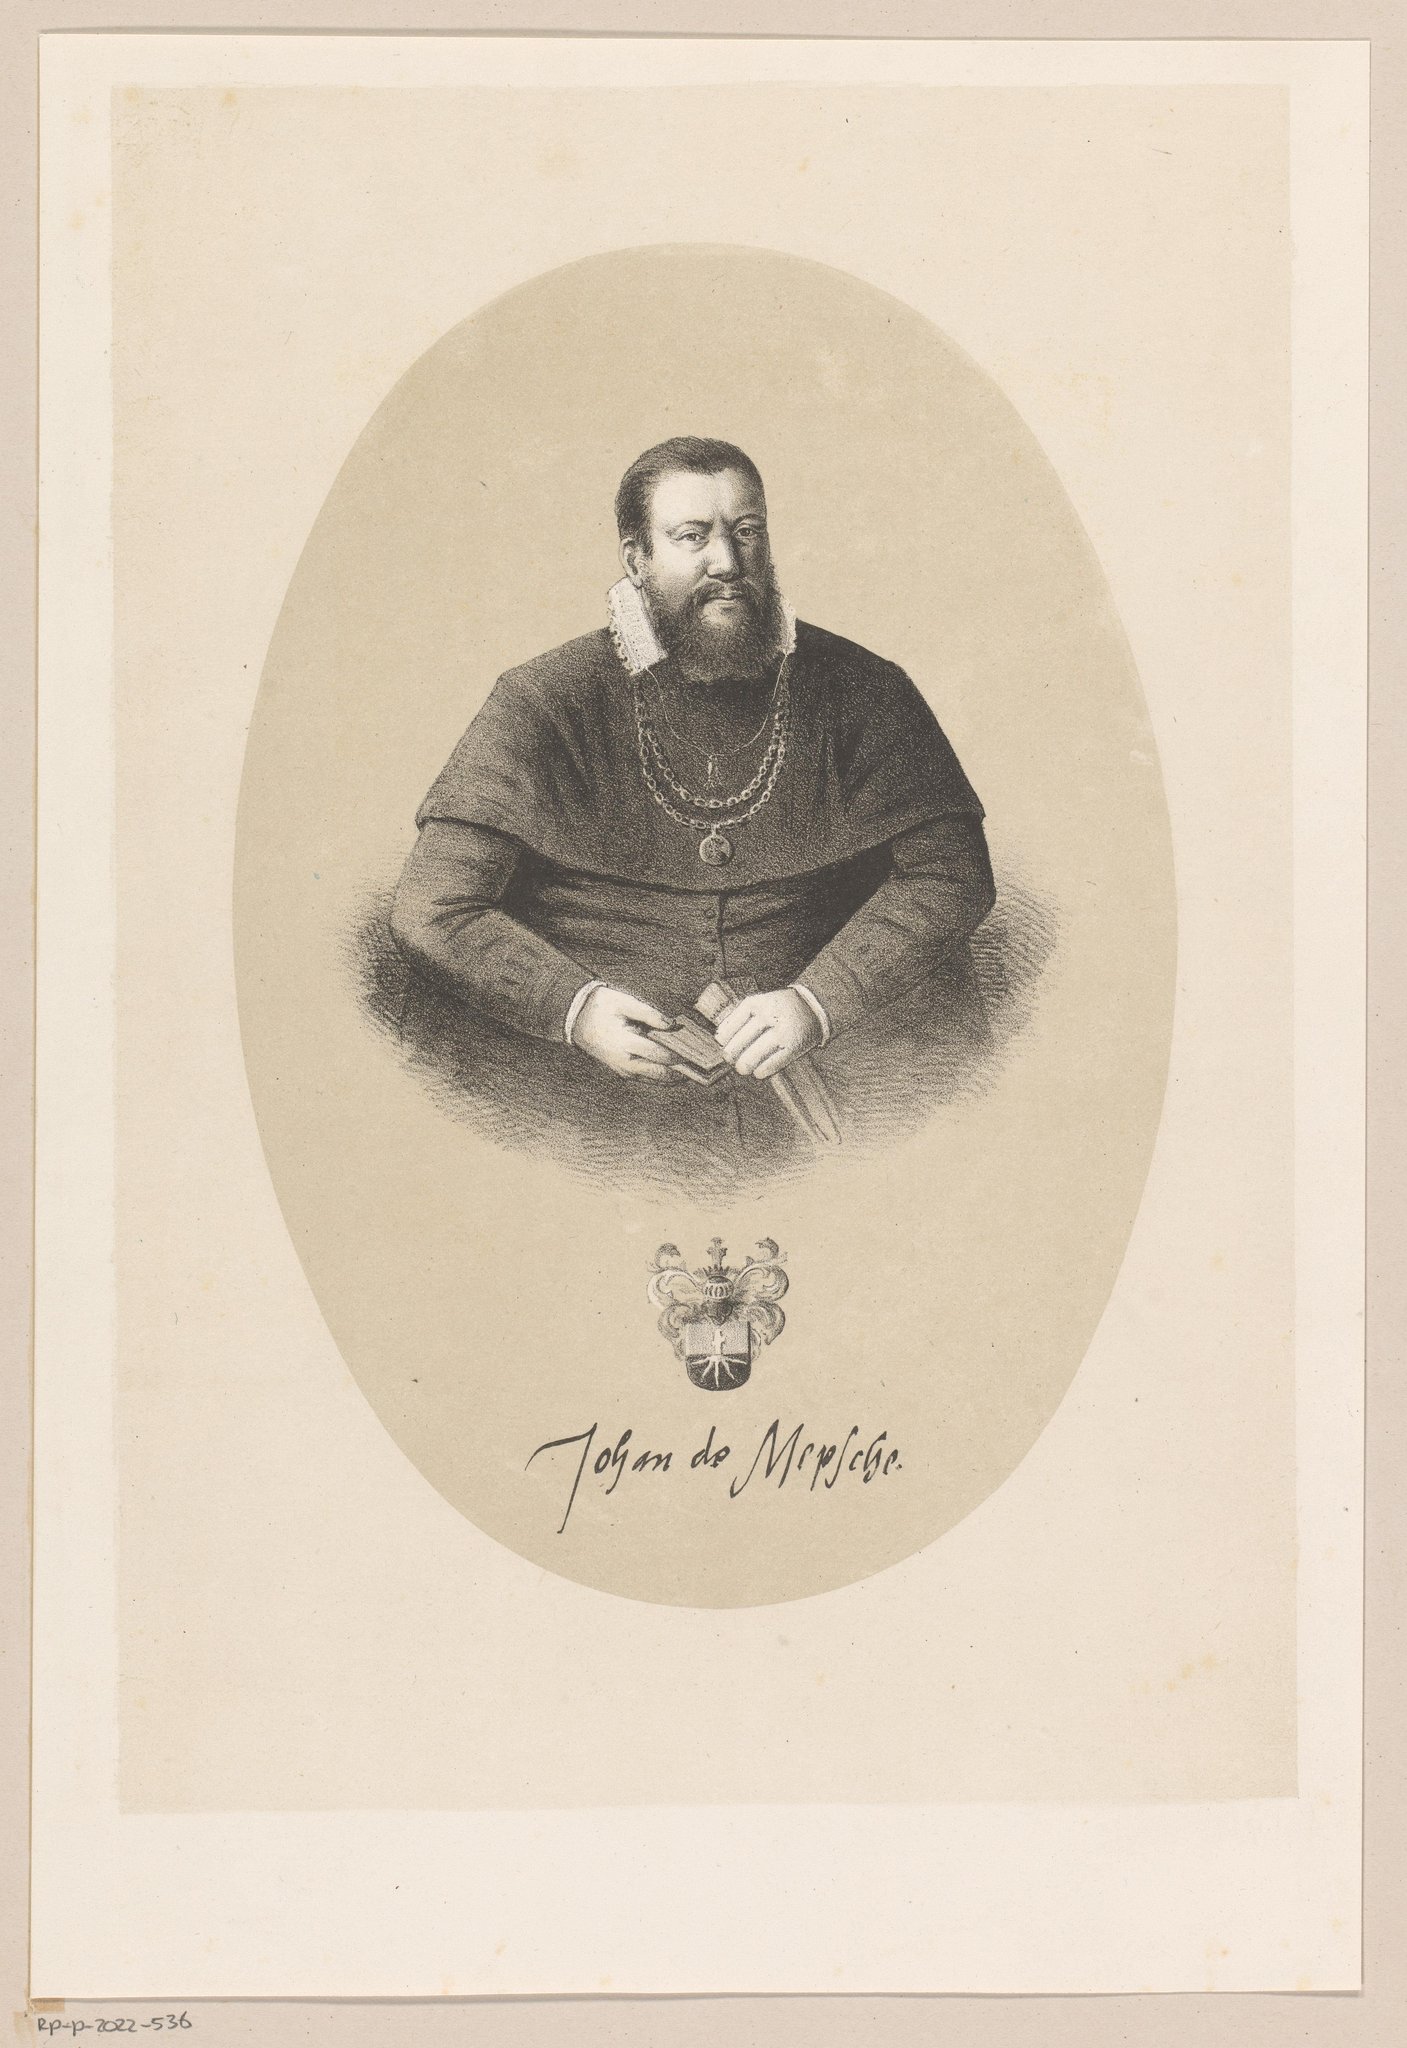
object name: print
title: Portret van Johan de Mepsche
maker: Anonymous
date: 1800-1950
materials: paper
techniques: tone lithography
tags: groningen (province), historical persons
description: Met facsimile signatuur van de geportretteerde.